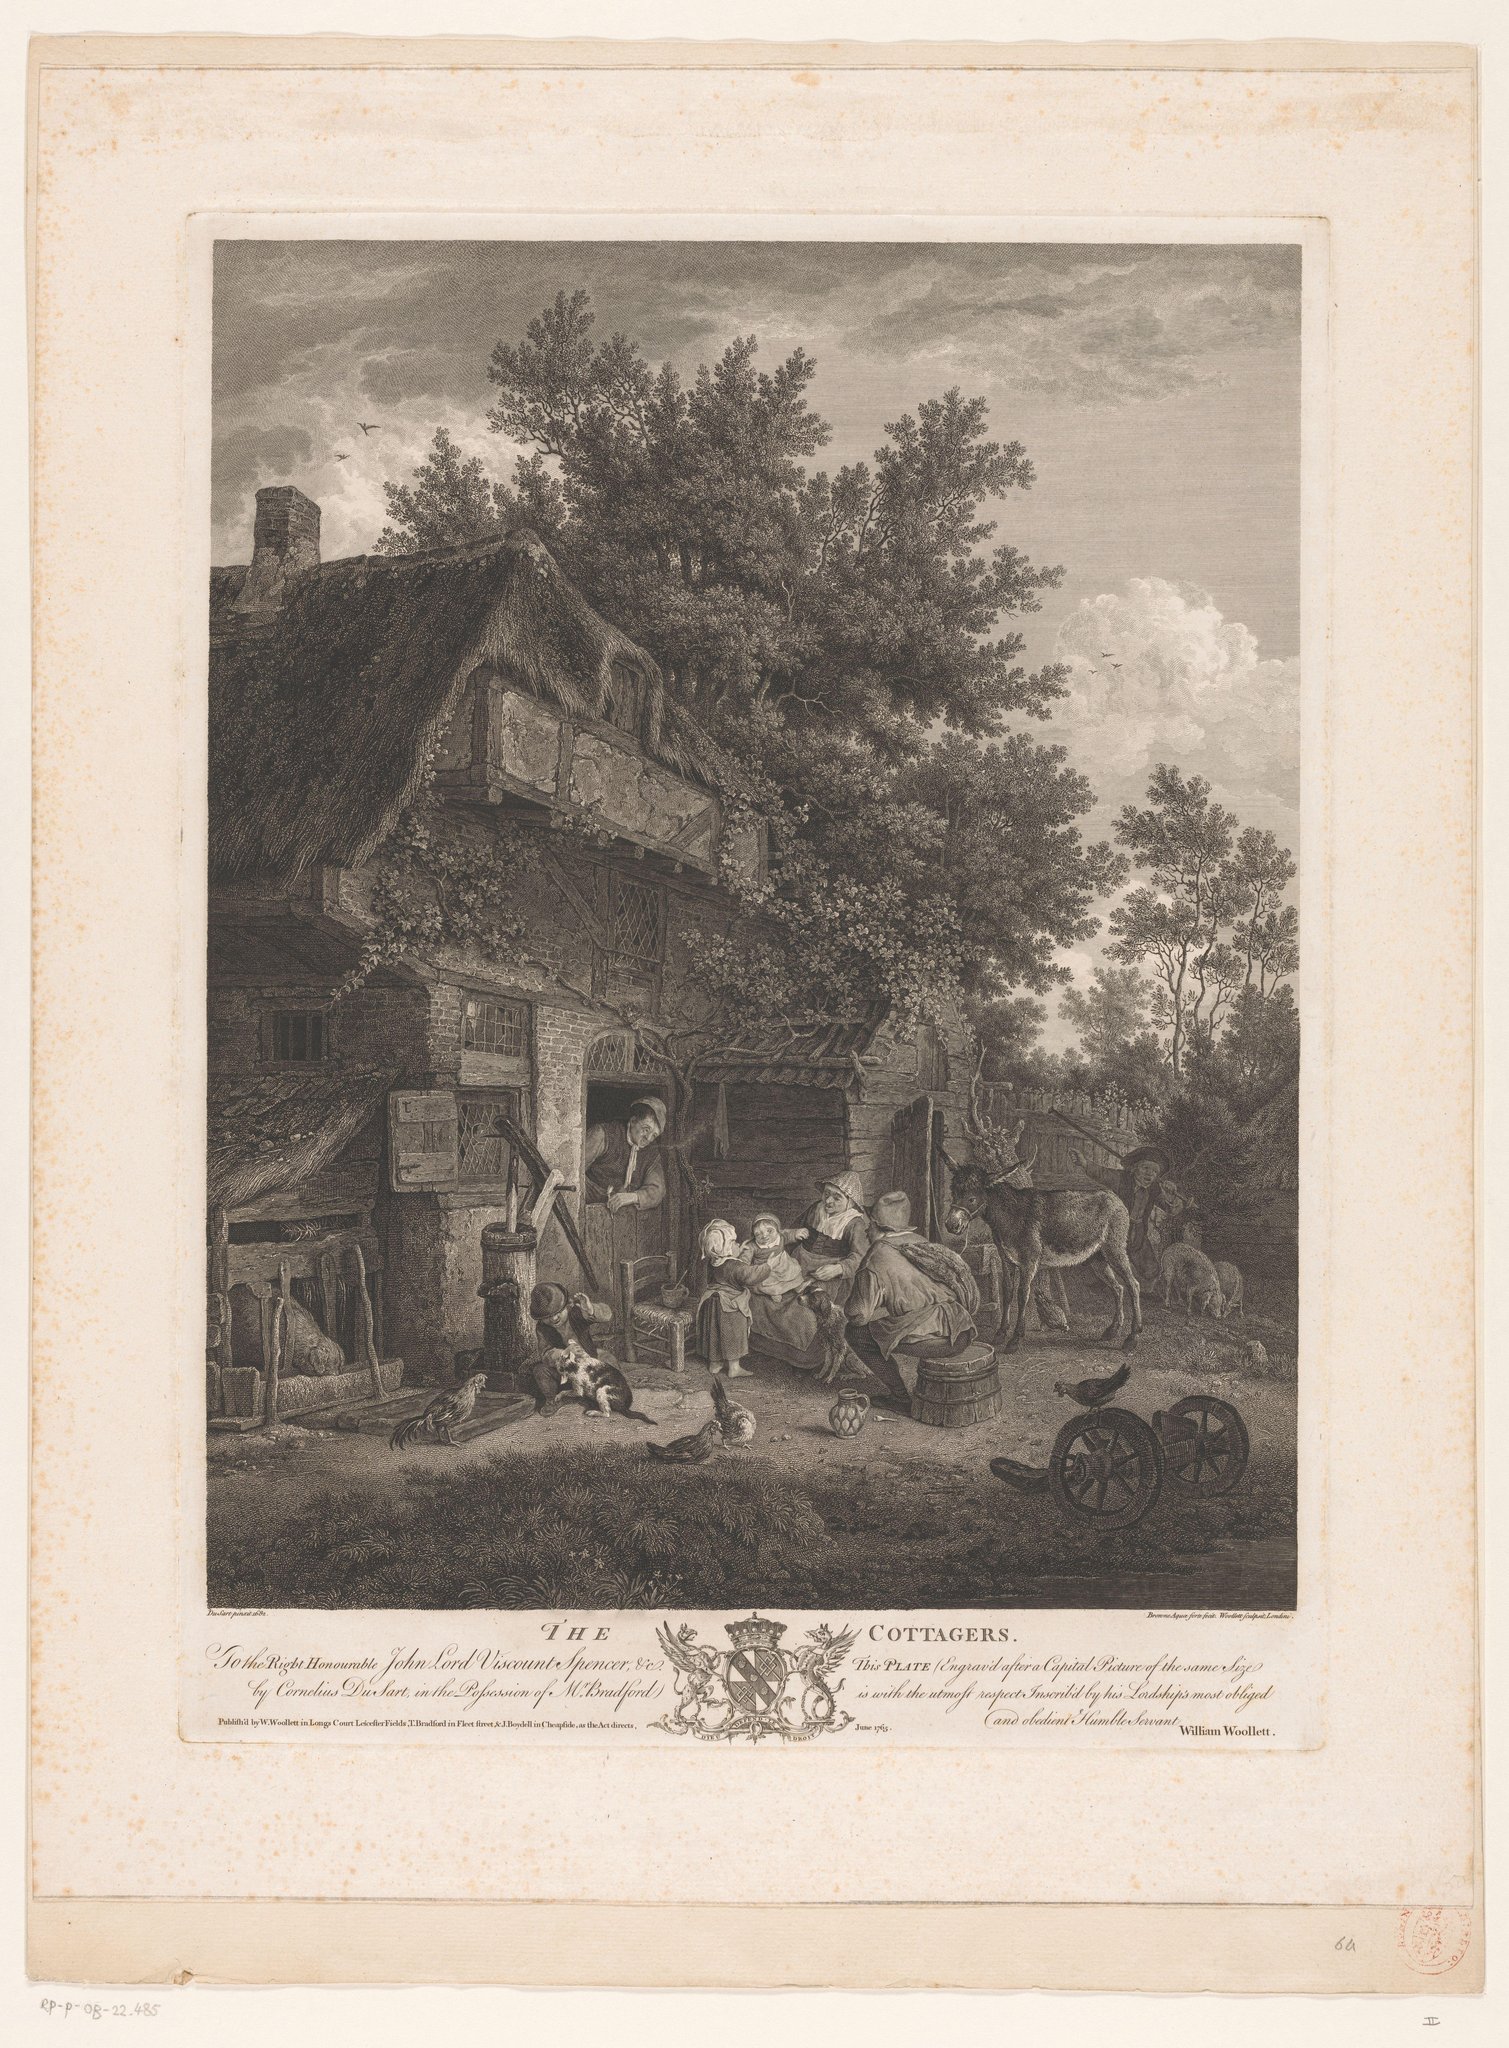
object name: print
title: The Cottagers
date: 1765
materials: paper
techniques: etching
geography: london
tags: family life, cottage, farm (building)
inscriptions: collector's mark: Lugt 240